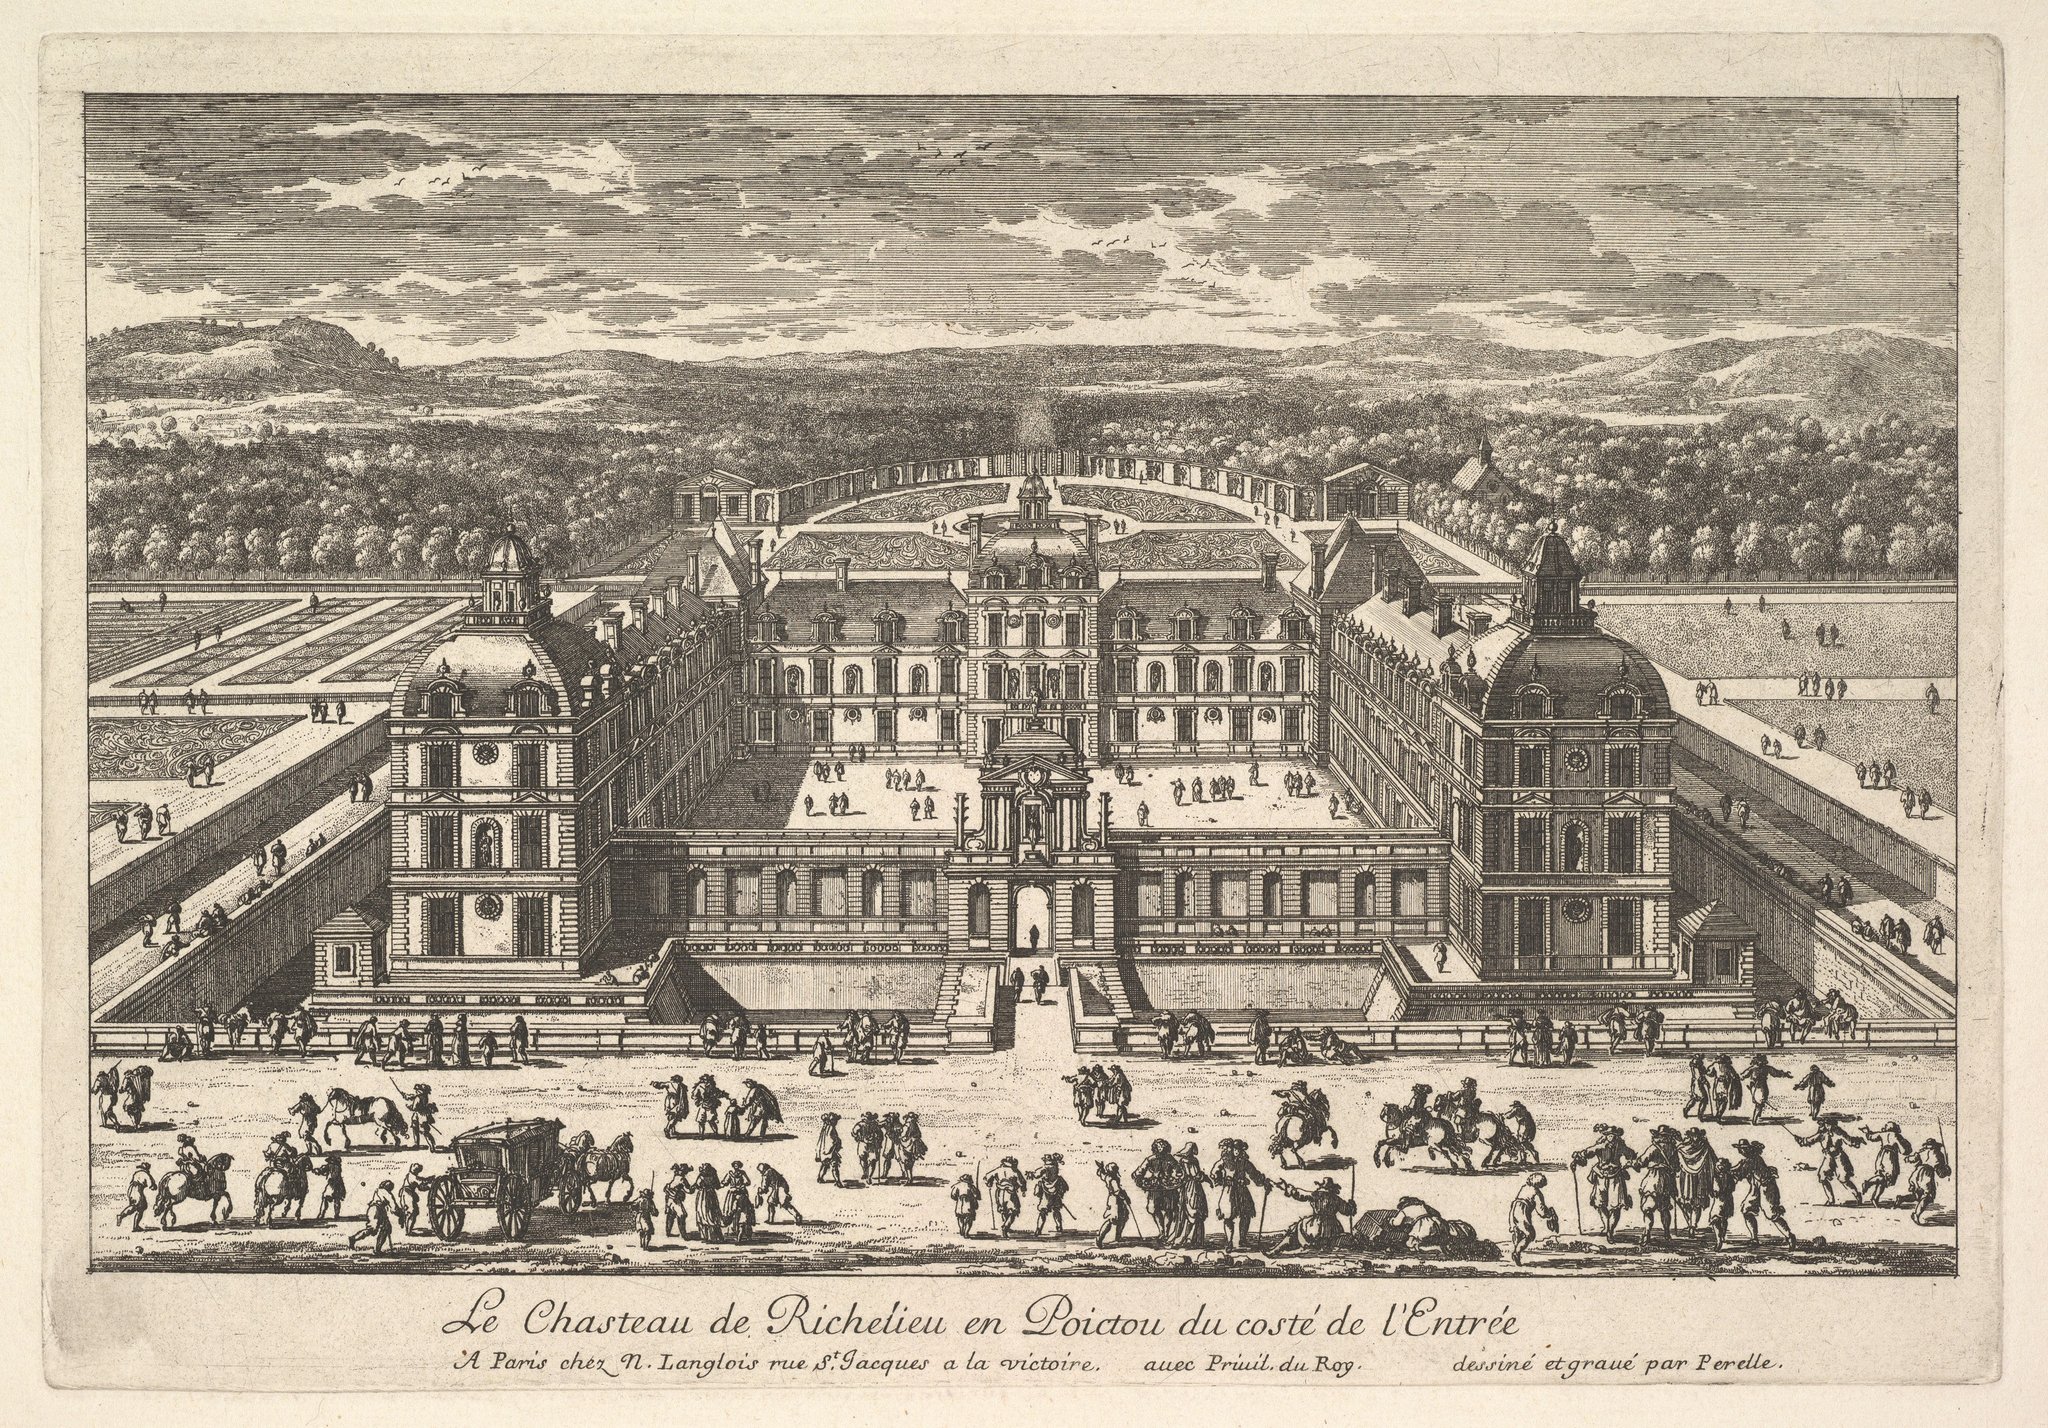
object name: print ornament architecture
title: Le Château de Richelieu en Poictou du Côté de l'Entrée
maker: adam perelle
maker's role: artist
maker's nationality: french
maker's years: 1640-1695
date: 1601-1700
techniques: etching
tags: architecture,palaces